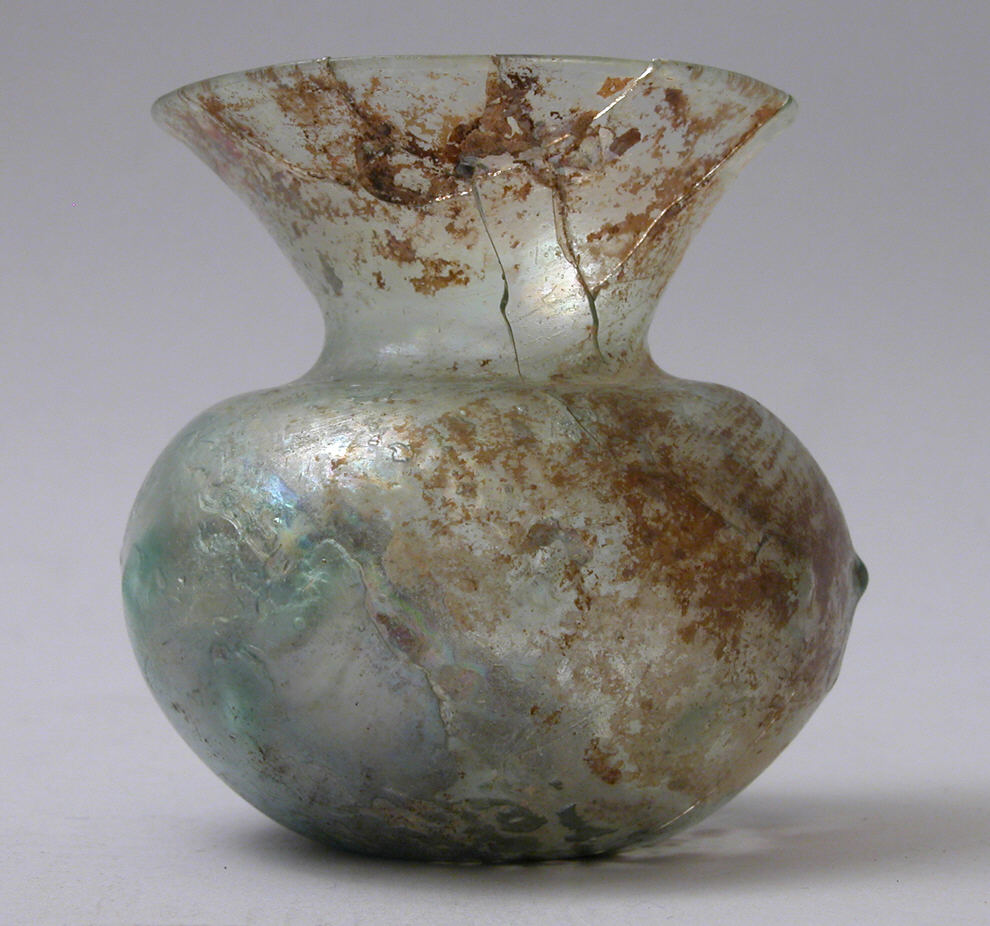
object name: jar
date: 301-500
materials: glass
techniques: glassblowing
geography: syria